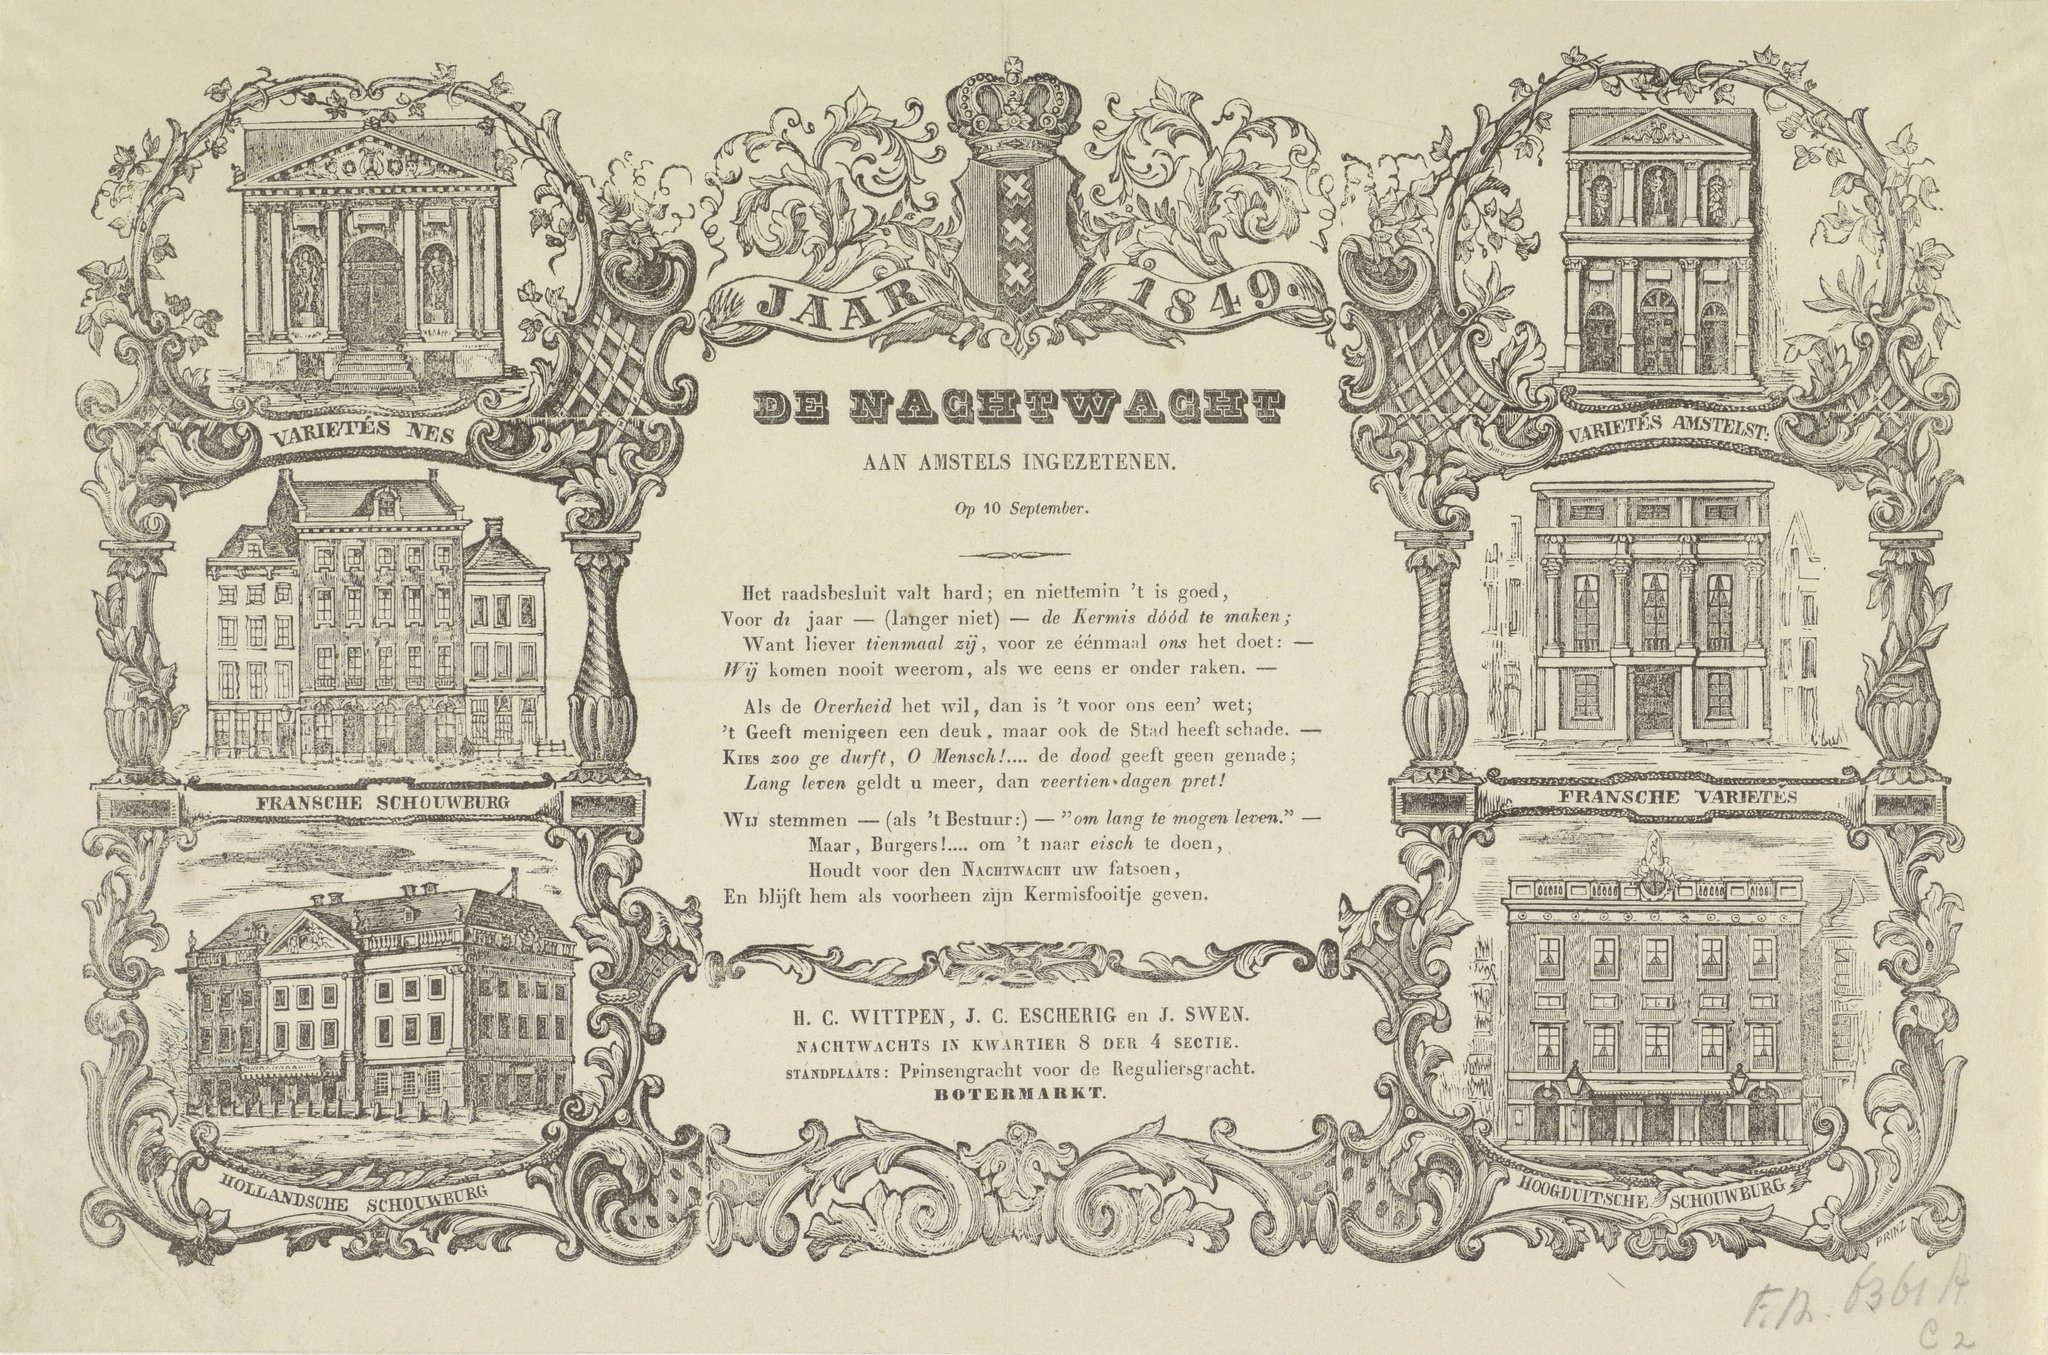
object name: print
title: Jaar 1849. De Nachtwacht aan Amstels Ingezetenen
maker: friedrich robert prinz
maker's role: print maker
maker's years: 1820-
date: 1849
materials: paper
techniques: letterpress printing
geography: netherlands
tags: night patrol, theatre (building), amsterdam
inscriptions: collector's mark: Lugt 2228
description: Kermisprent van de Amsterdamse nachtwacht (ratelwacht), 10 september 1849. Tussen bladeren en ranken afbeeldingen van: de Variété aan de Nes, de Franse Schouwburg, de Hollandse Schouwburg, de Oude Salon de Variété in de Amstelstraat, de Franse Variétés en de Hoogduitse schouwburg. Met een vers in drie delen. Namens de nachtwacht in kwartier No. 8 van de 4e sectie: H.C. Wittpen, J.C. Escherig en J. Swen.